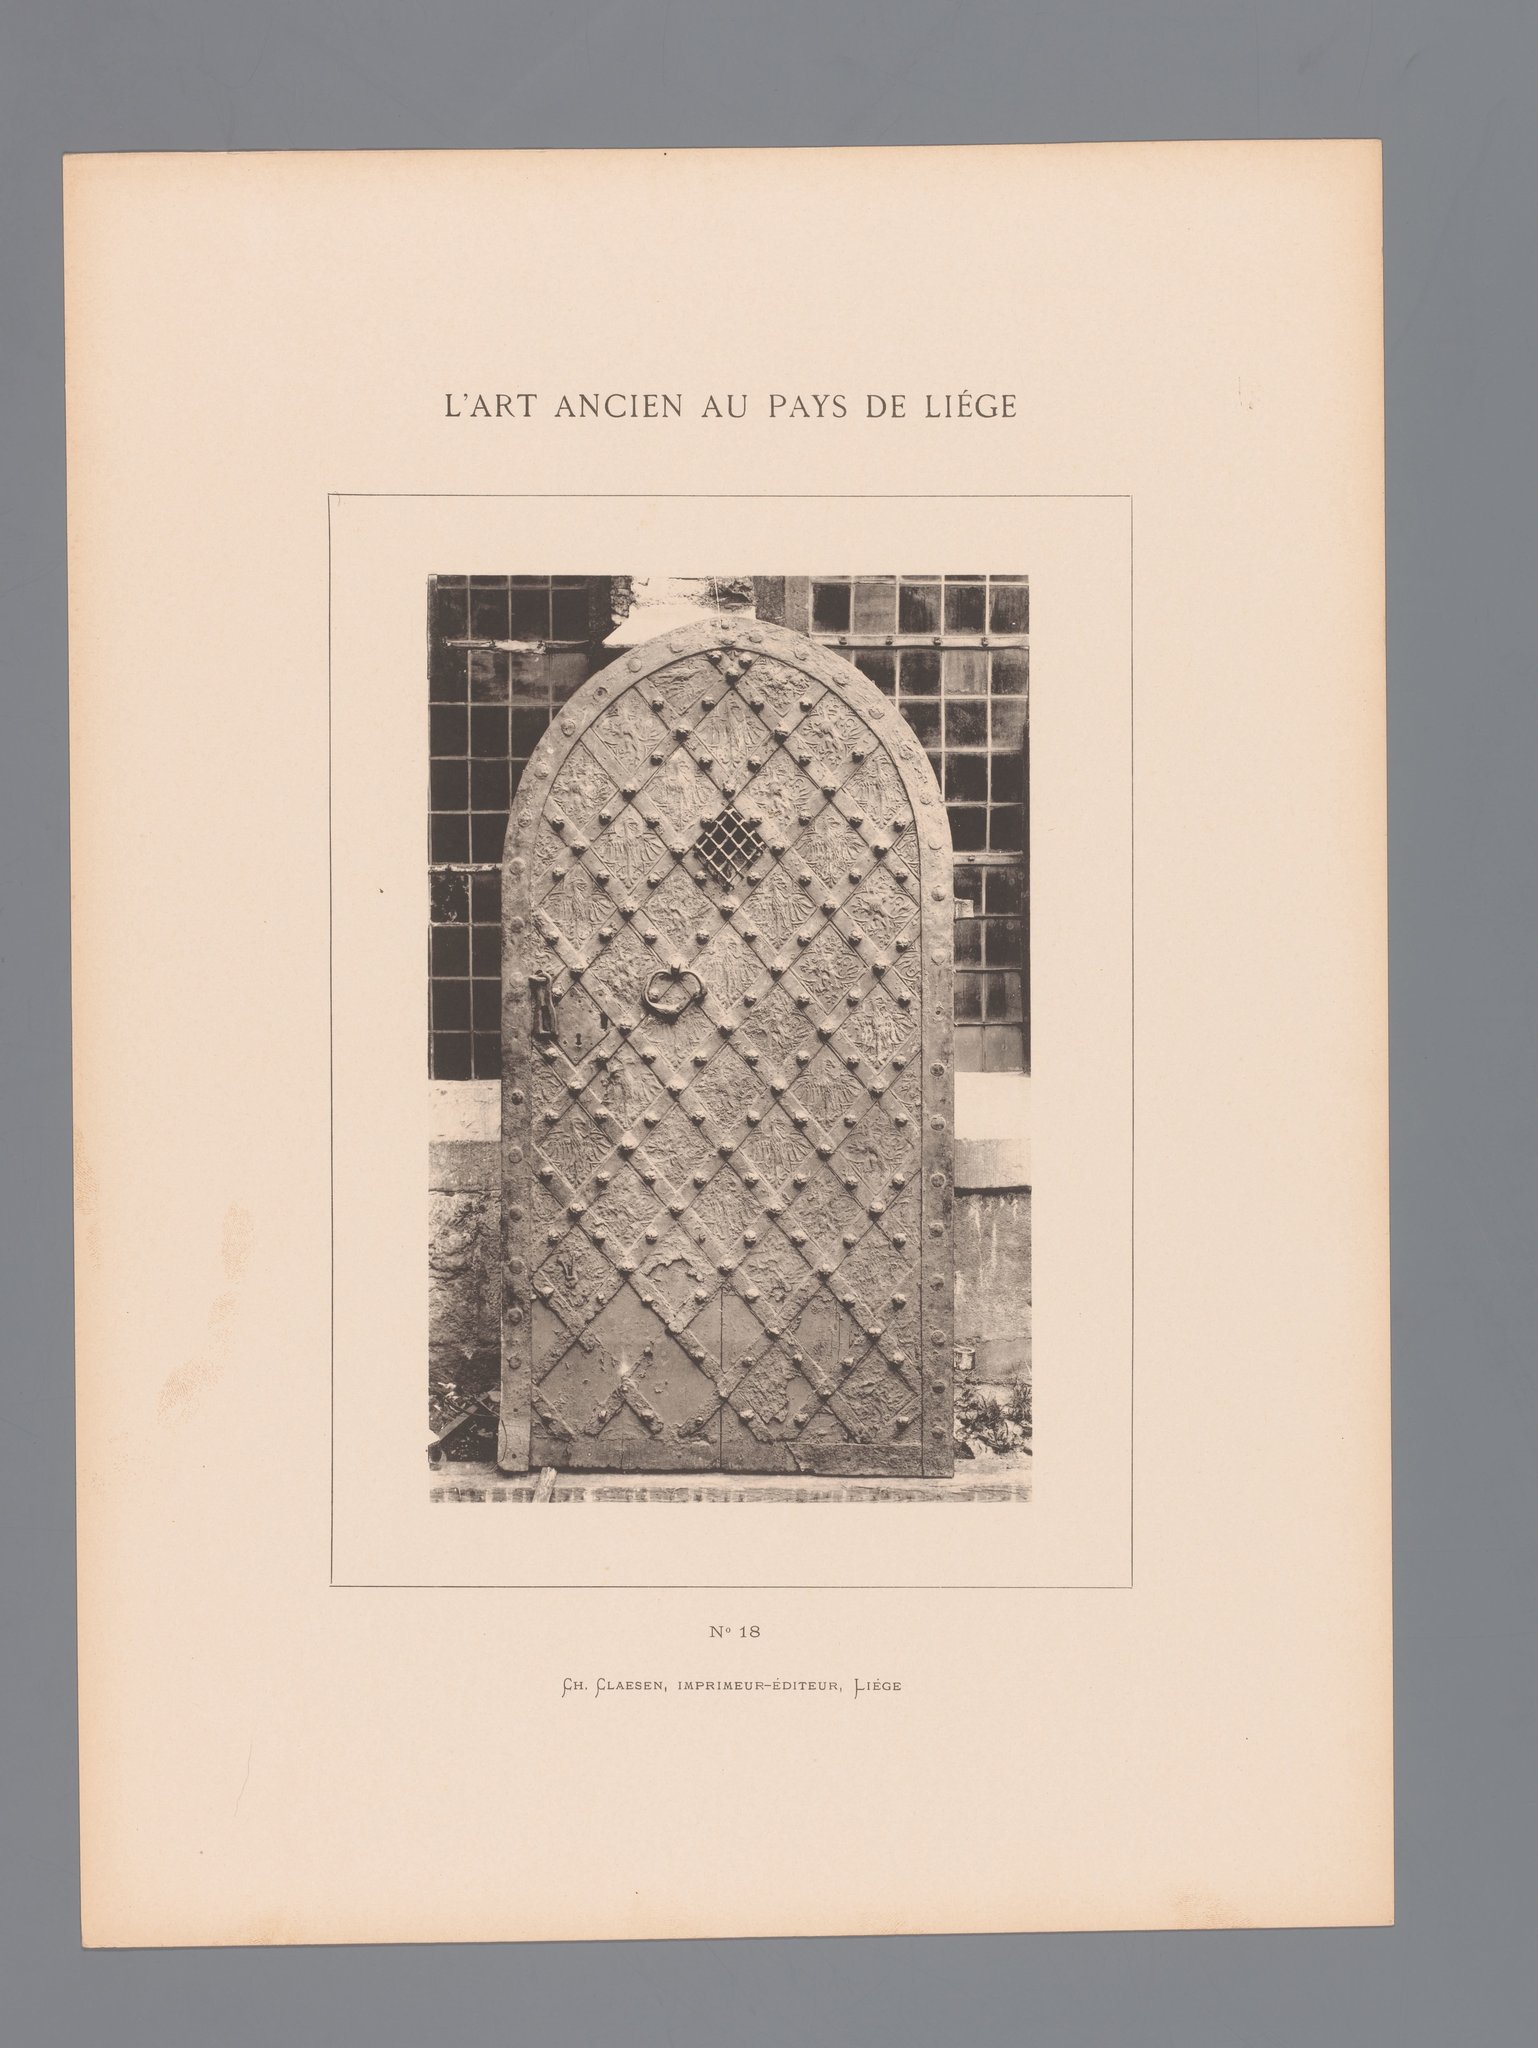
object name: photomechanical print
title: L'Art Ancien au Pays de Liége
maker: Anonymous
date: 1879-1884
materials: paper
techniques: photograph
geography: liège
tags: door, liège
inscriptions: number: ‘No 18’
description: Deze prent maakt deel uit van een omslag met twintig prenten, een titelblad en een lijst van afbeeldingen.